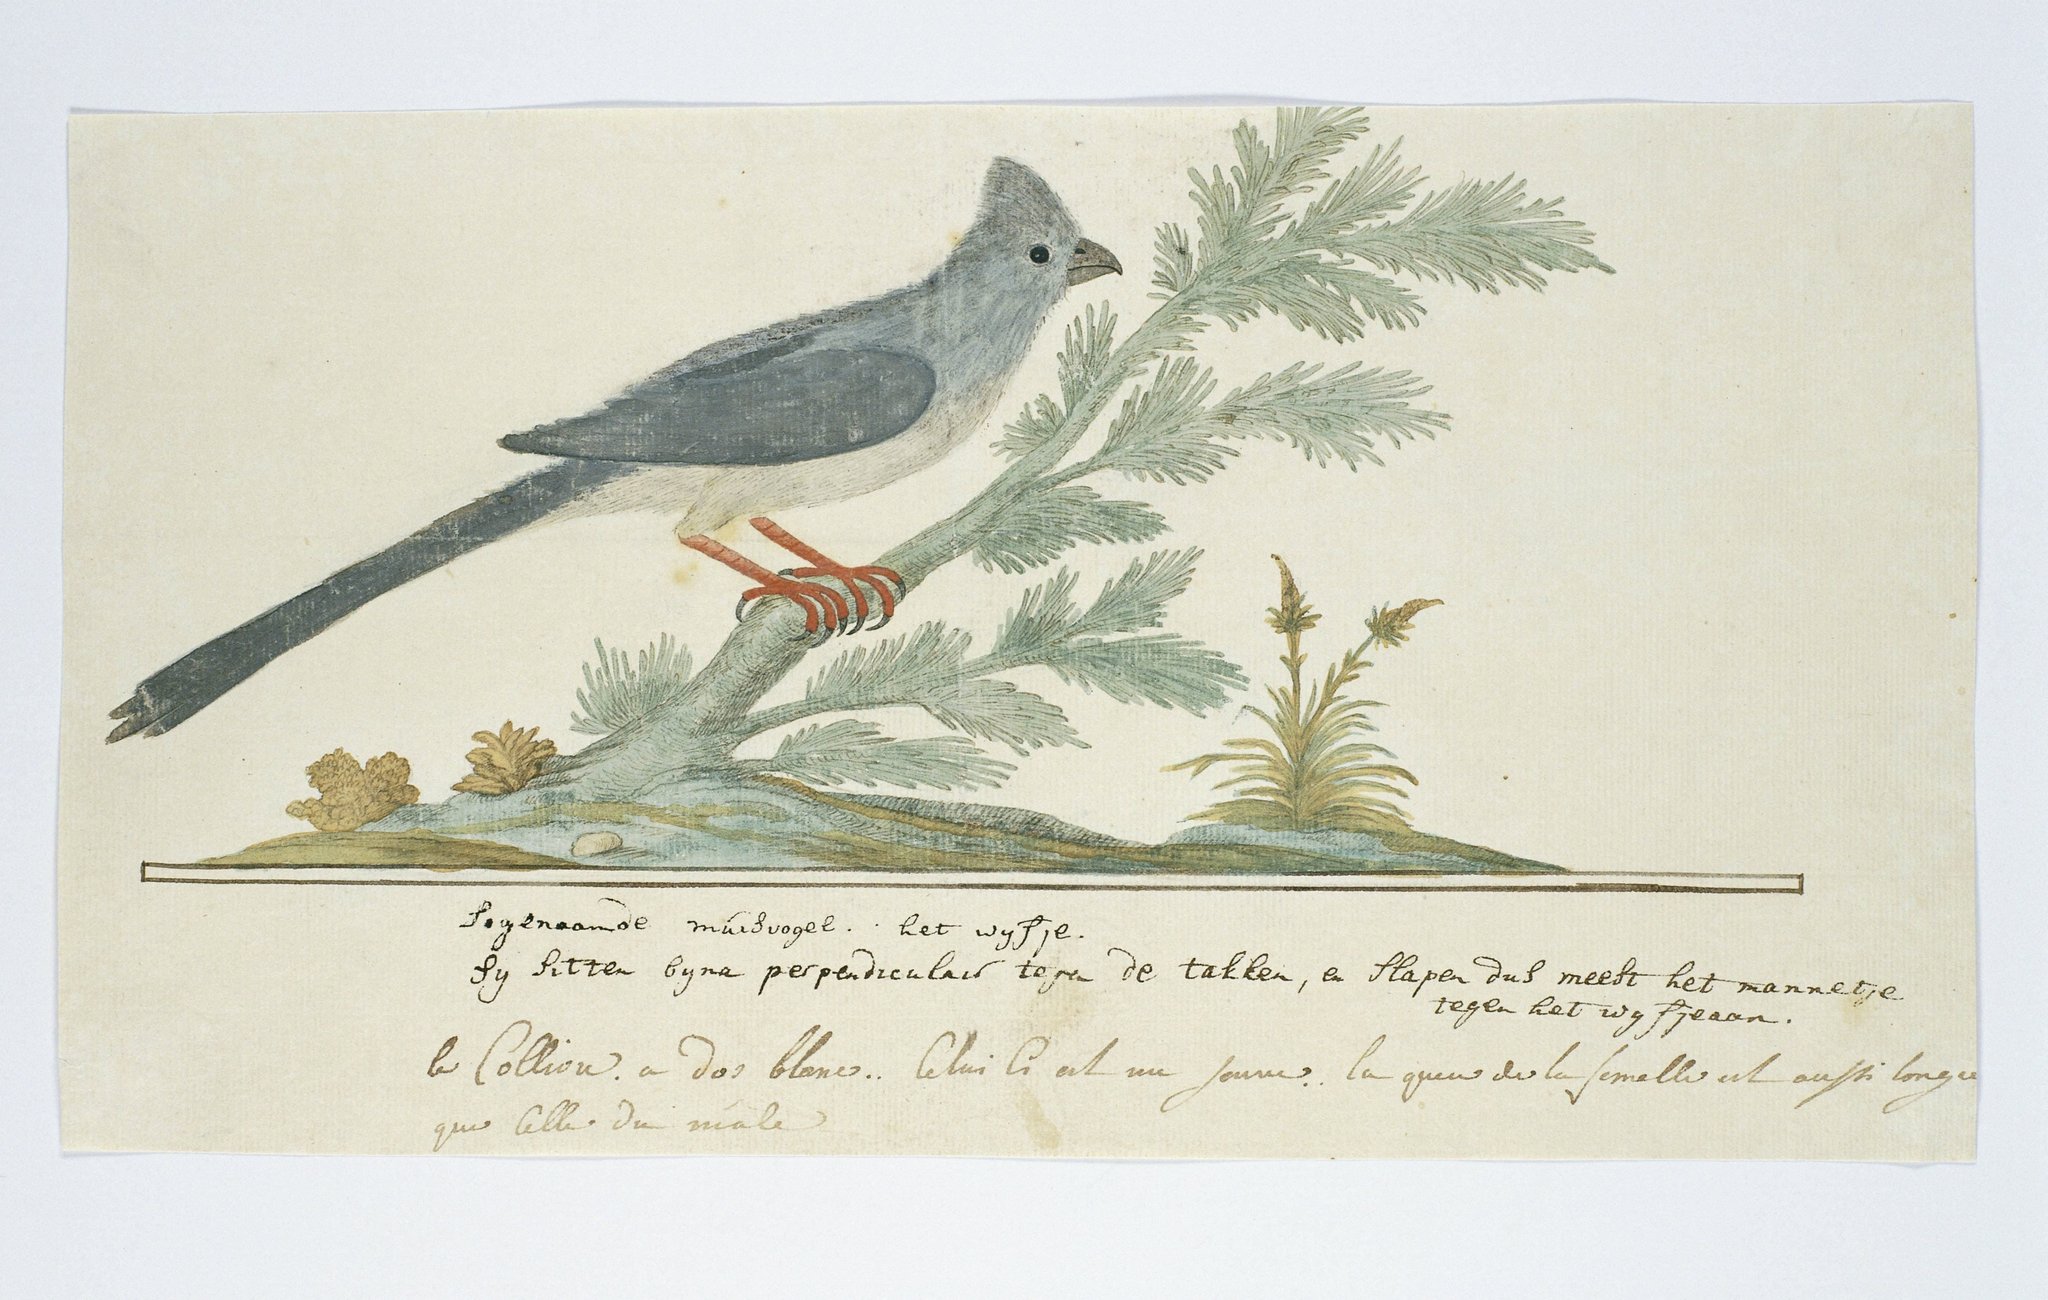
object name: album leaf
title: Colius striatus ? (Speckled mousebird)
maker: robert jacob gordon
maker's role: draughtsman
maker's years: 1743-1795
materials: chalk, ink, paper, pencil, watercolor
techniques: brush, pen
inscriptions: annotation: ‘Sogenaamde muisvogel. het wijfje. / [...] / le Collion a dos blanc. [...]’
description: Speckled mousebird (Eng.). Franse benaming geschreven door Levaillant.